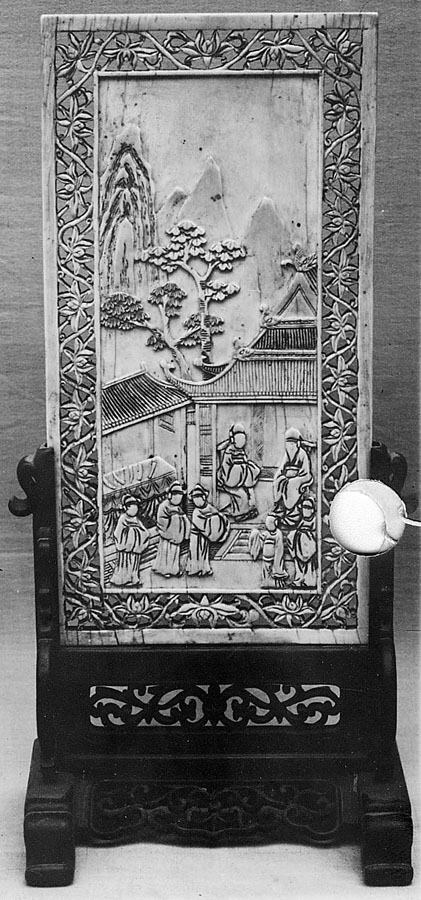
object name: table screen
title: Pair of Table Screens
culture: chinese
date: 1736-1795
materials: ivory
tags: mountains,trees